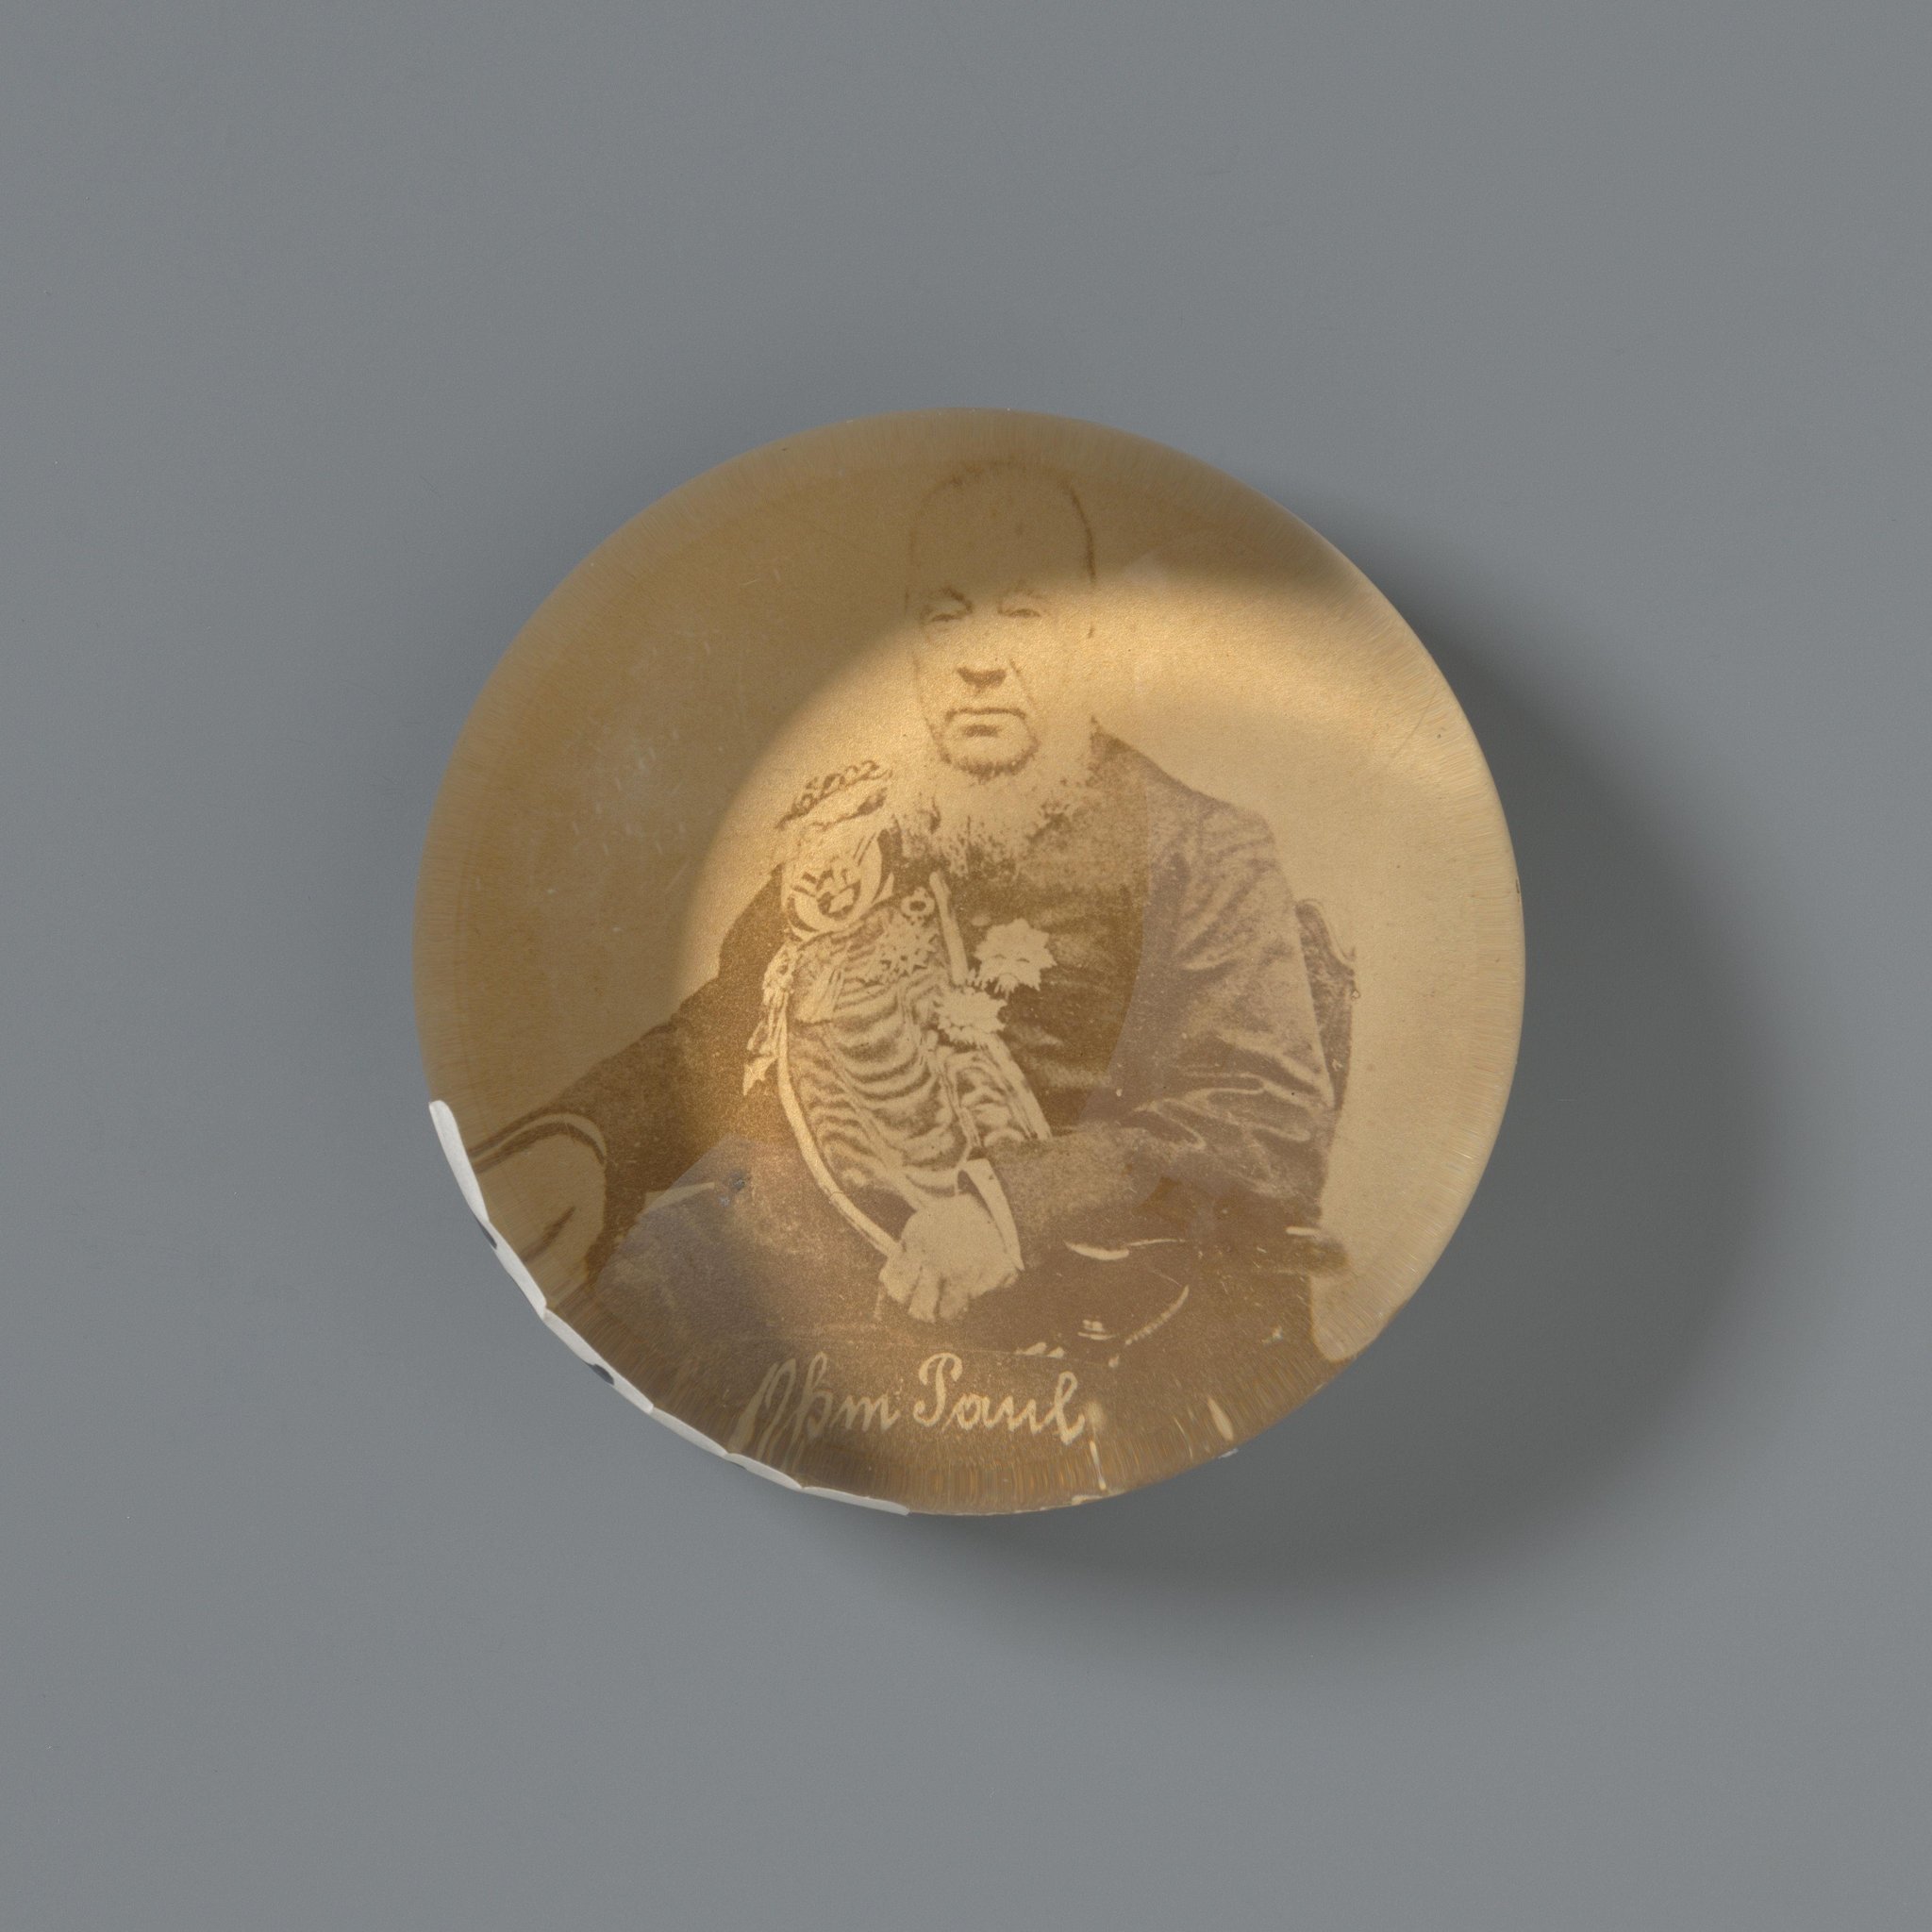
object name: paperweight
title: Presse-papier met portret van Paul Kruger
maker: Anonymous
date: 1883-1904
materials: glass, paper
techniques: albumen print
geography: south africa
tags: president ~ head of republic, historical persons